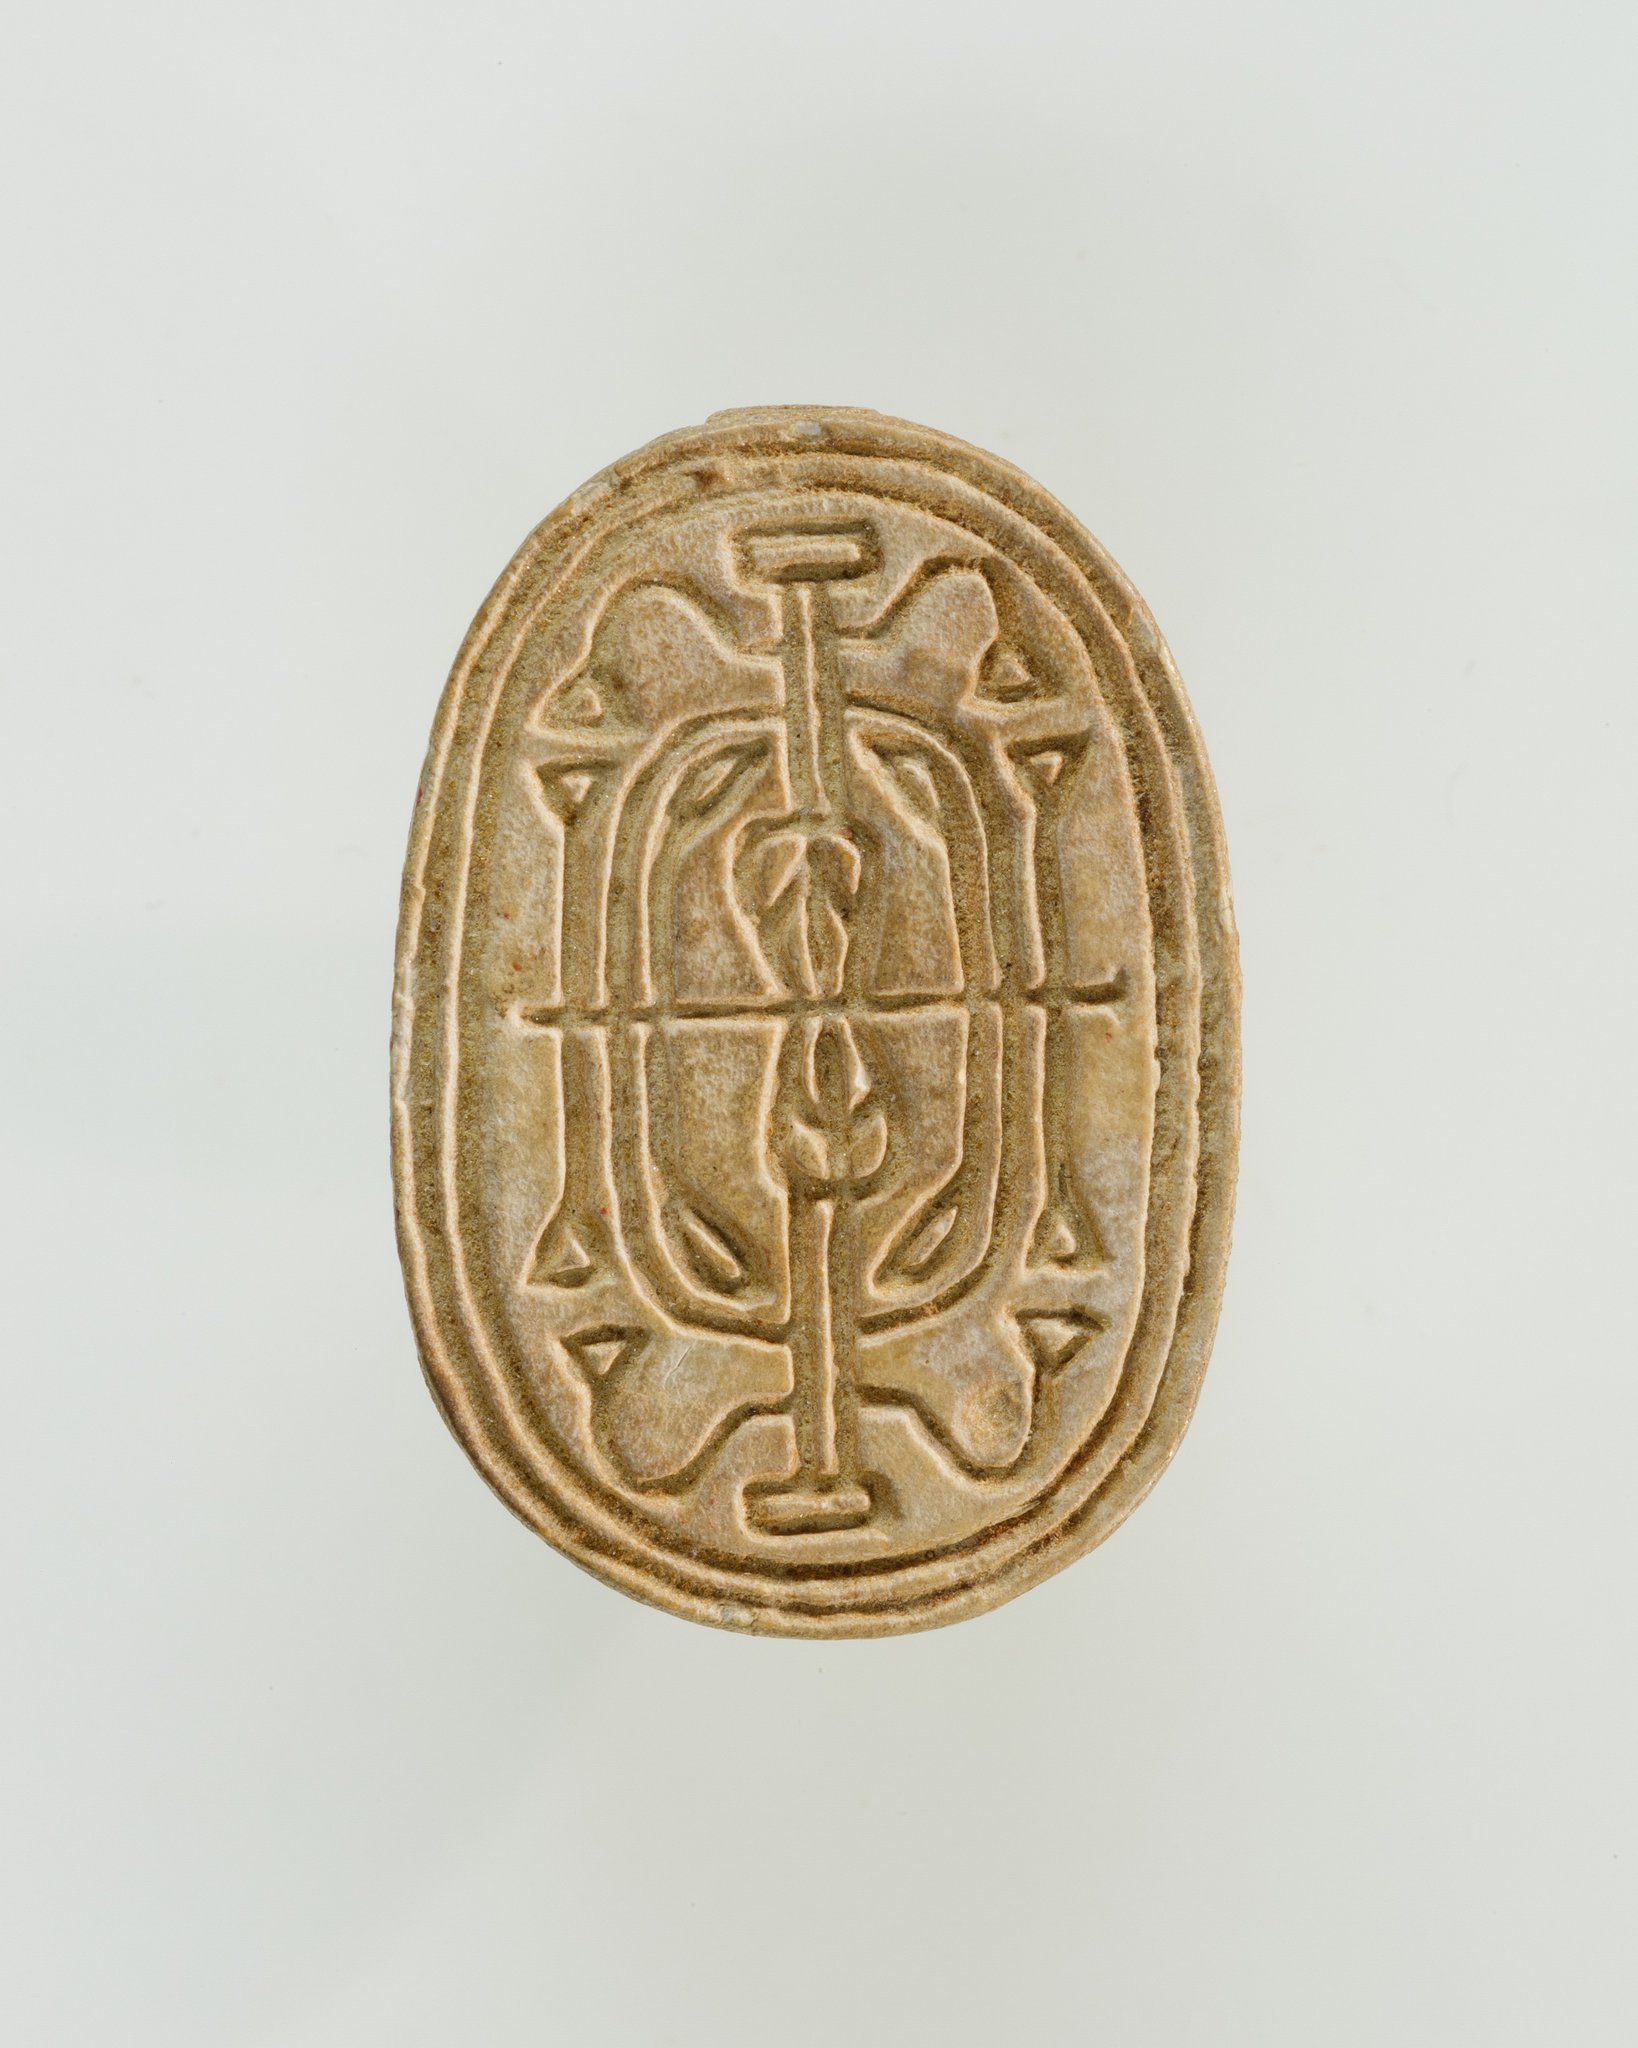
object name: scarab, sema tawy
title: Scarab Decorated with Symbol of Unification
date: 1802-1670 BCE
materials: faience, glaze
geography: egypt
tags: scarabs